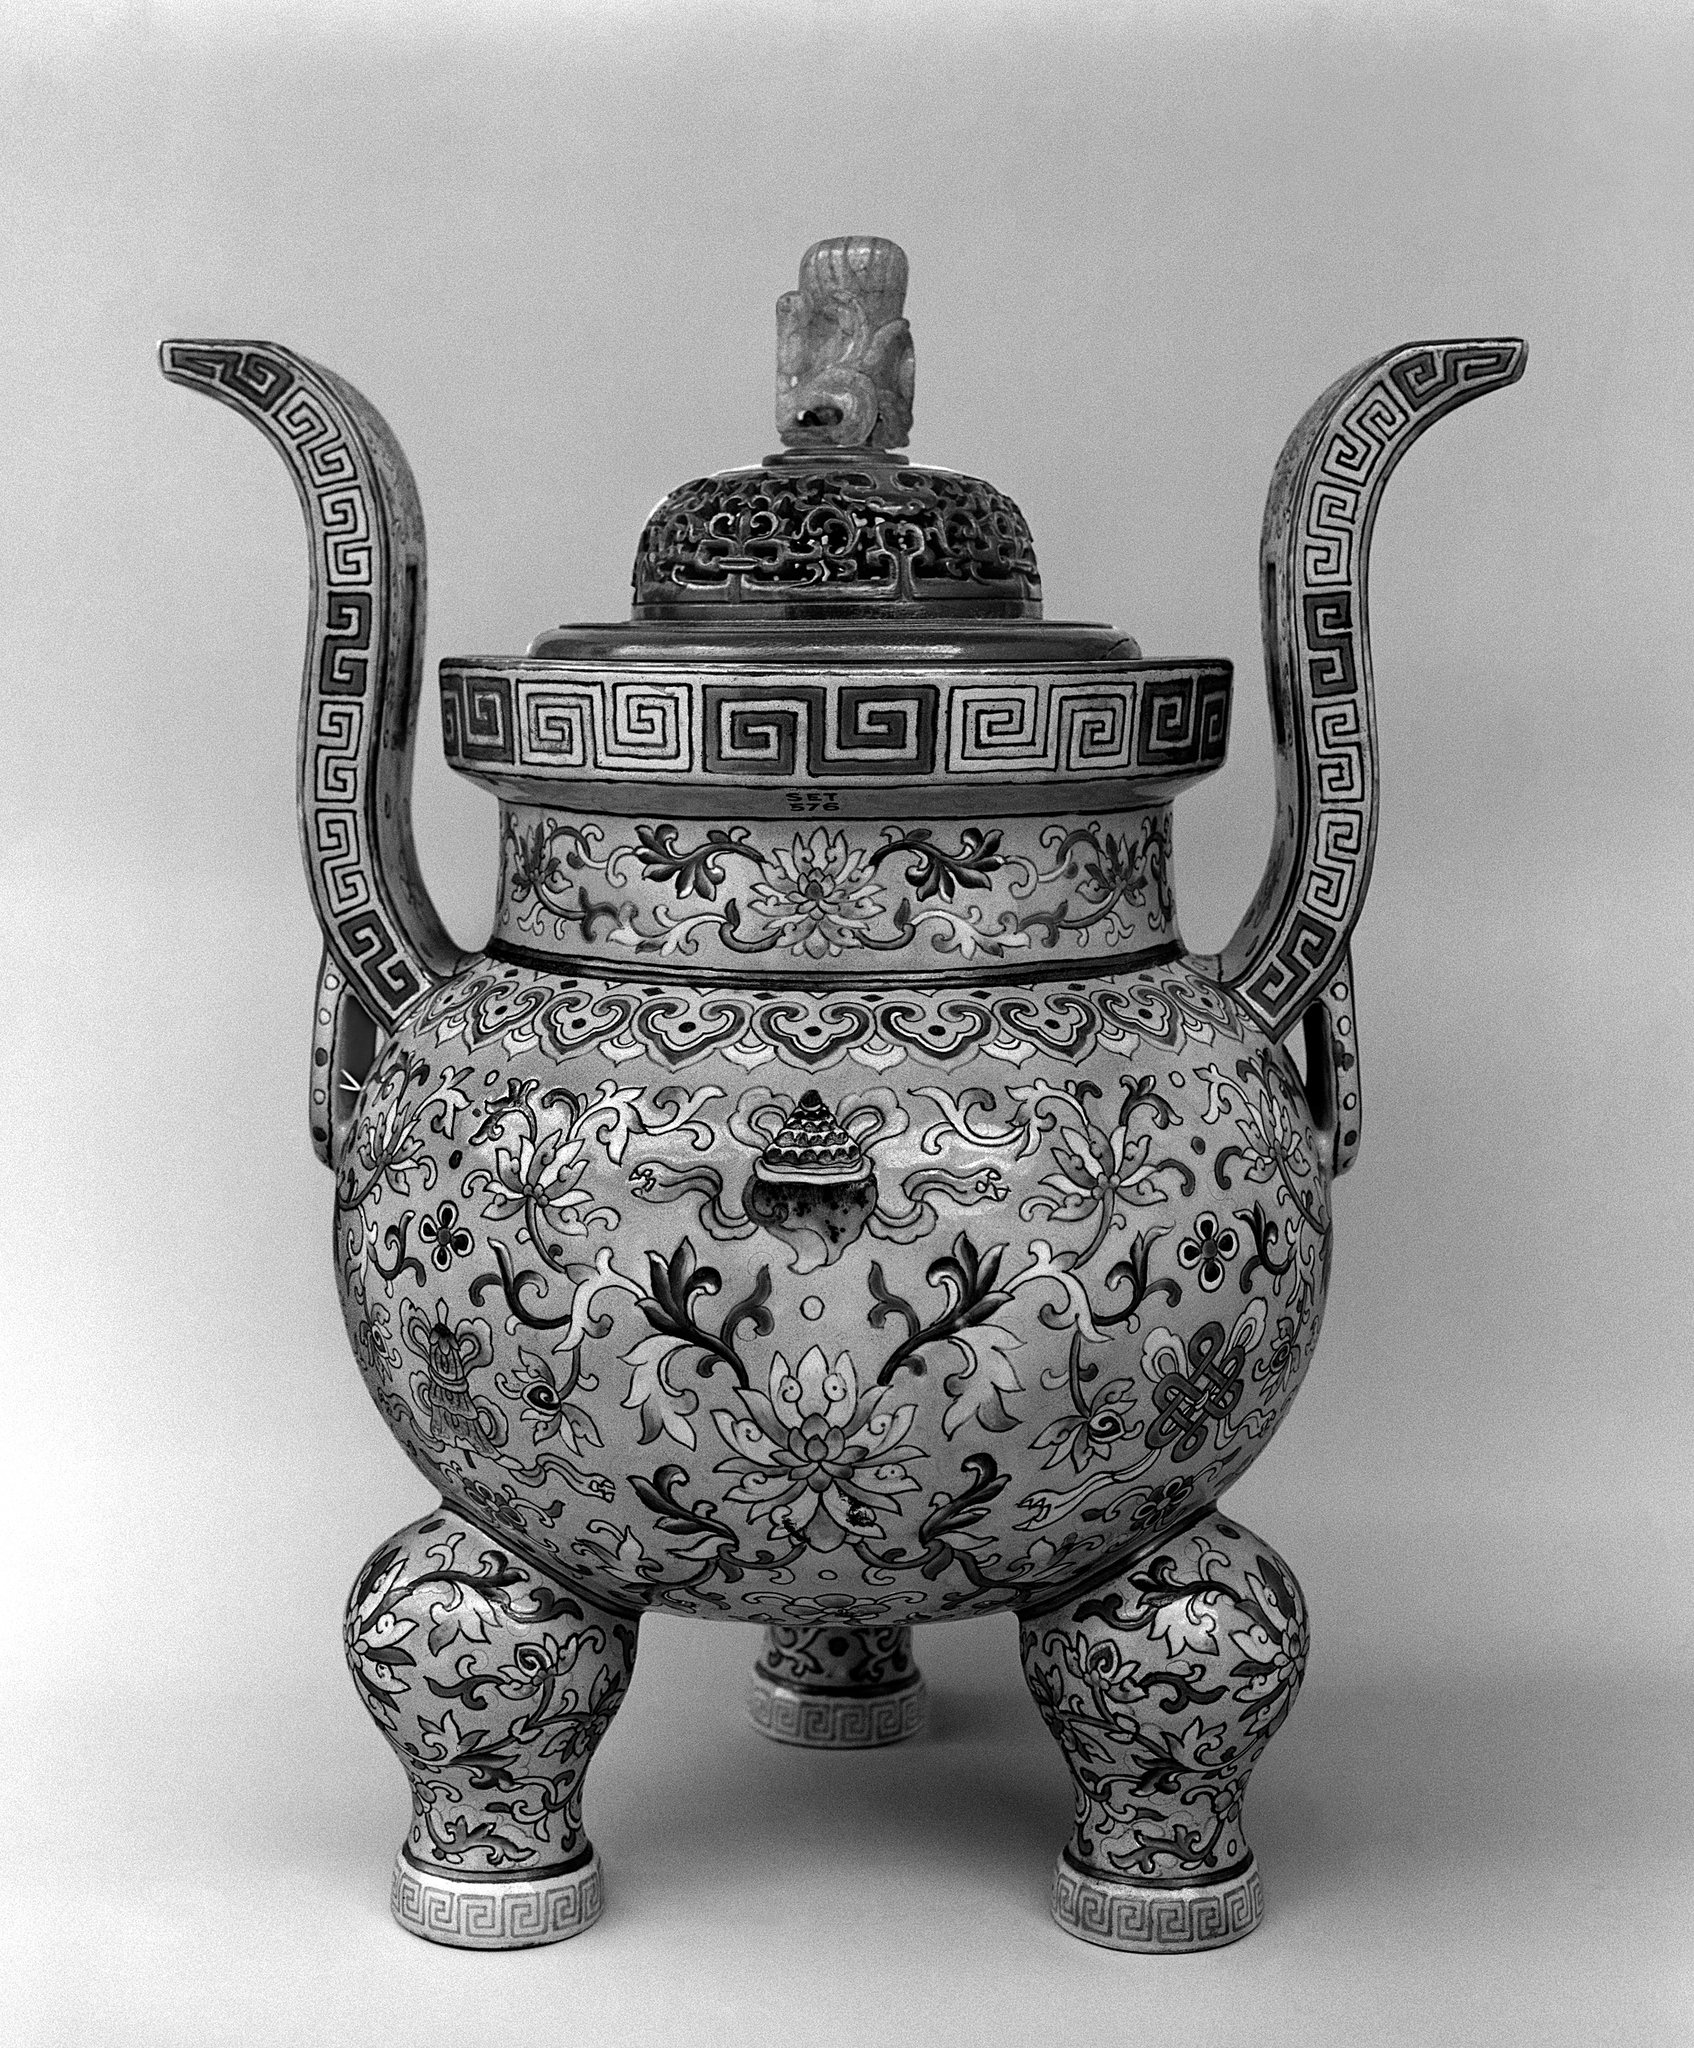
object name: altar set piece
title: Incense Burner from a Set of Five-Piece Altar Set (Wugong)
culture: chinese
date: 1821-1850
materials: porcelain